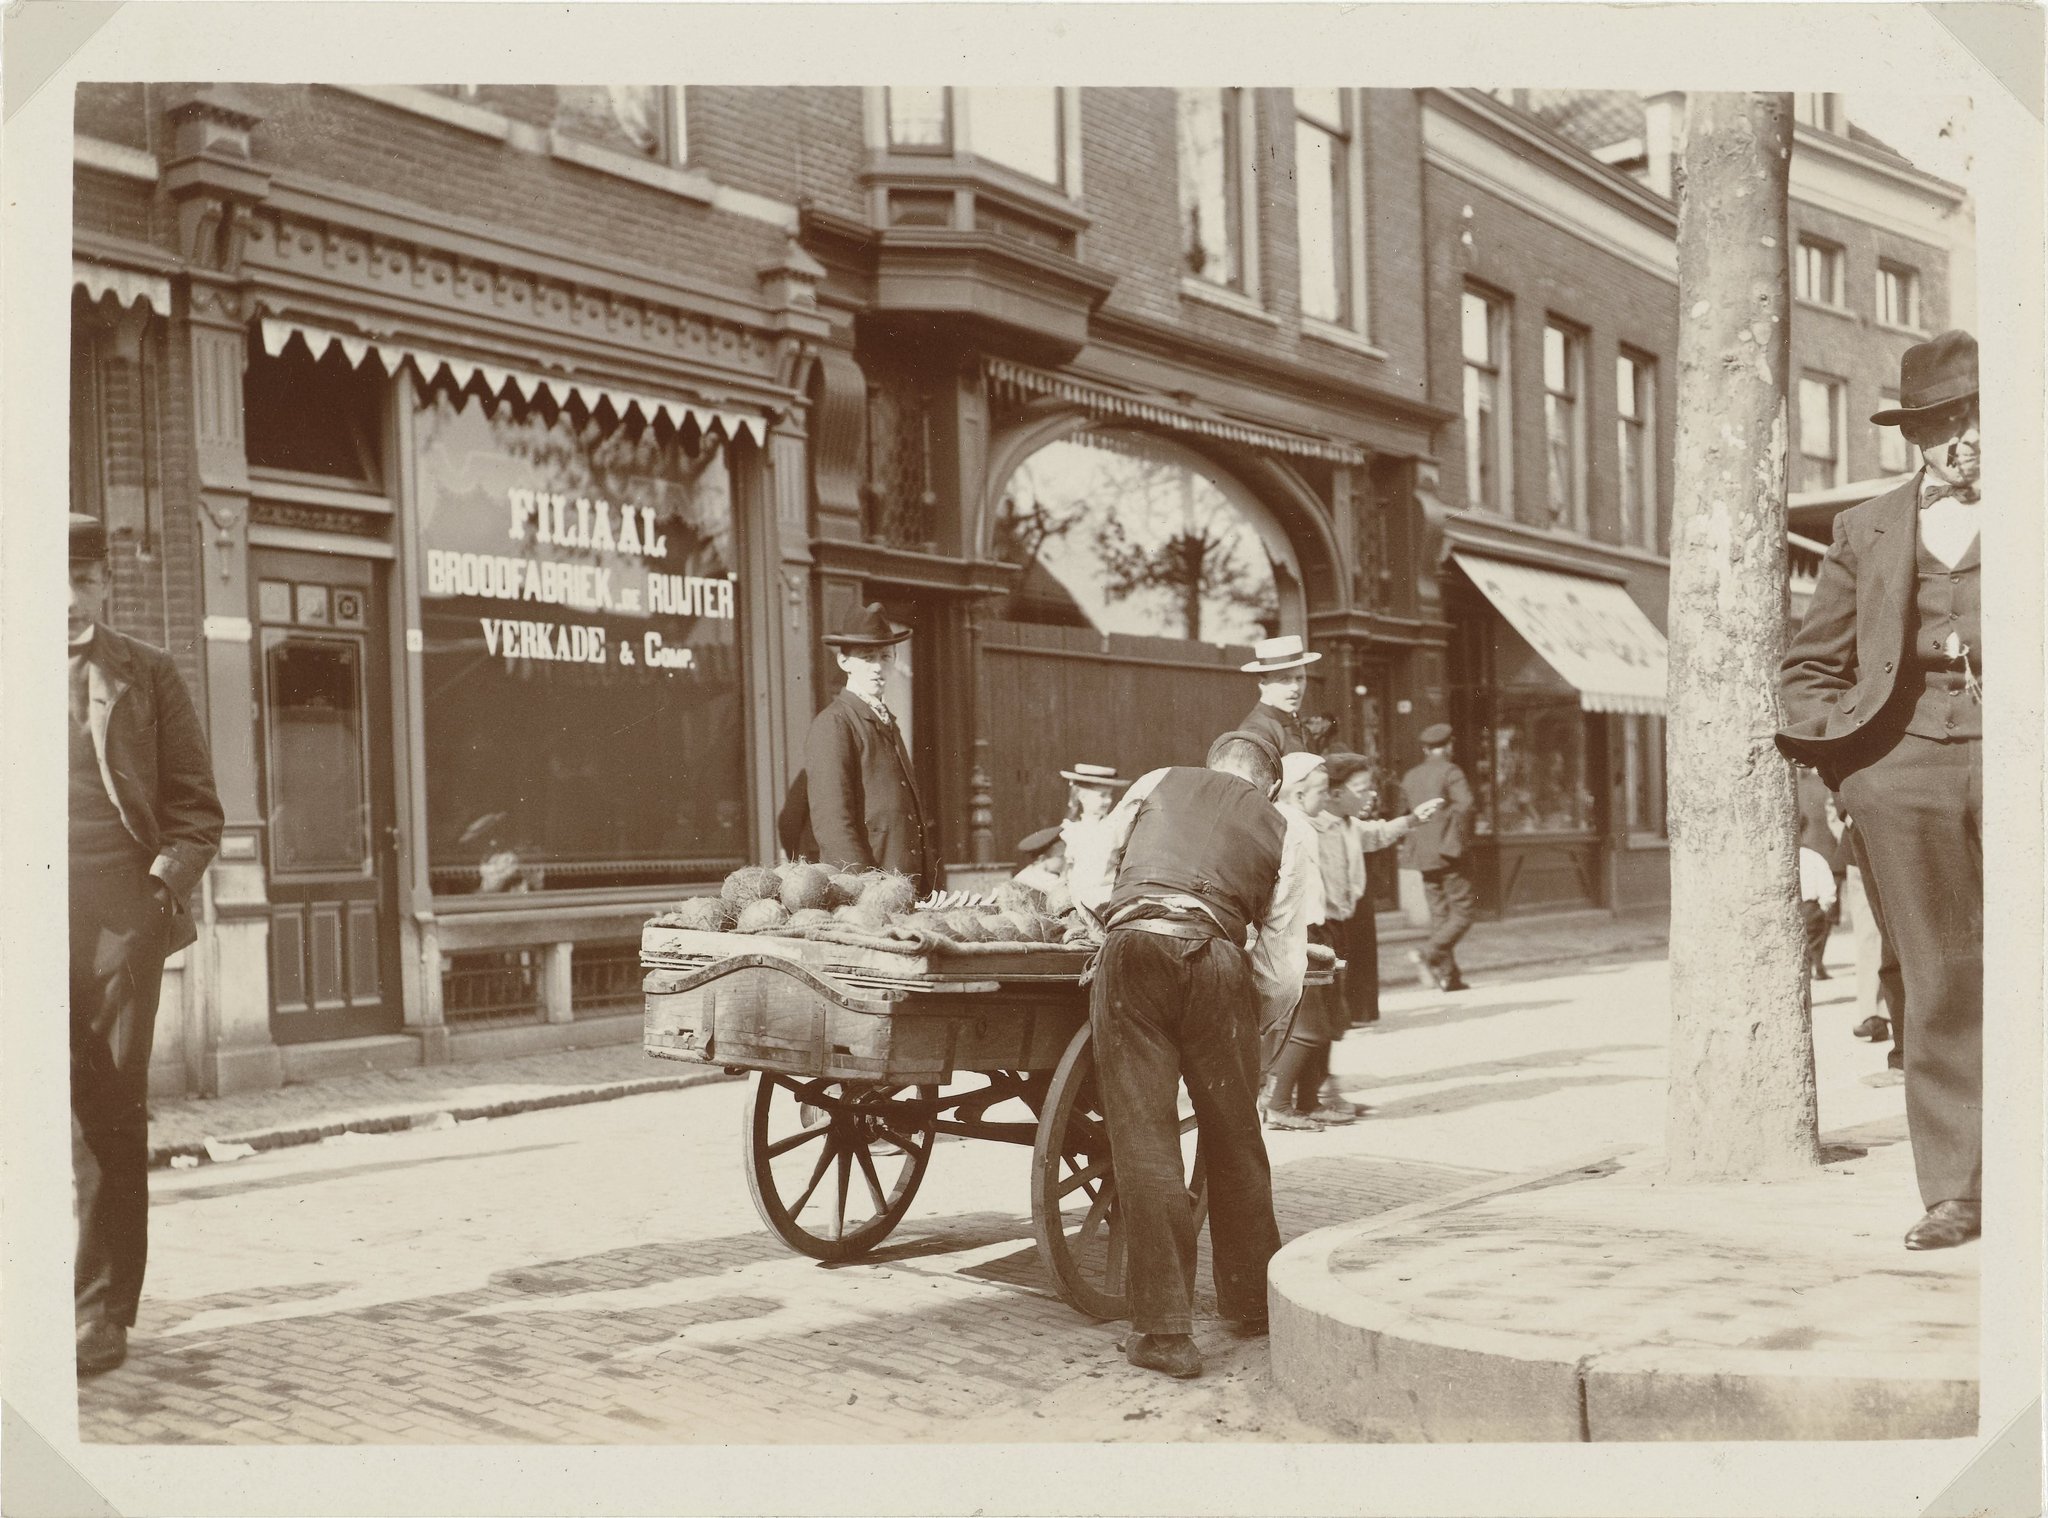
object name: photograph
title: Vendor with a barrow in an unknown city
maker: james higson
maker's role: politician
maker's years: 1862-1933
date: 1904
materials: paper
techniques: gelatin silver print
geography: zaandam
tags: merchant, salesman